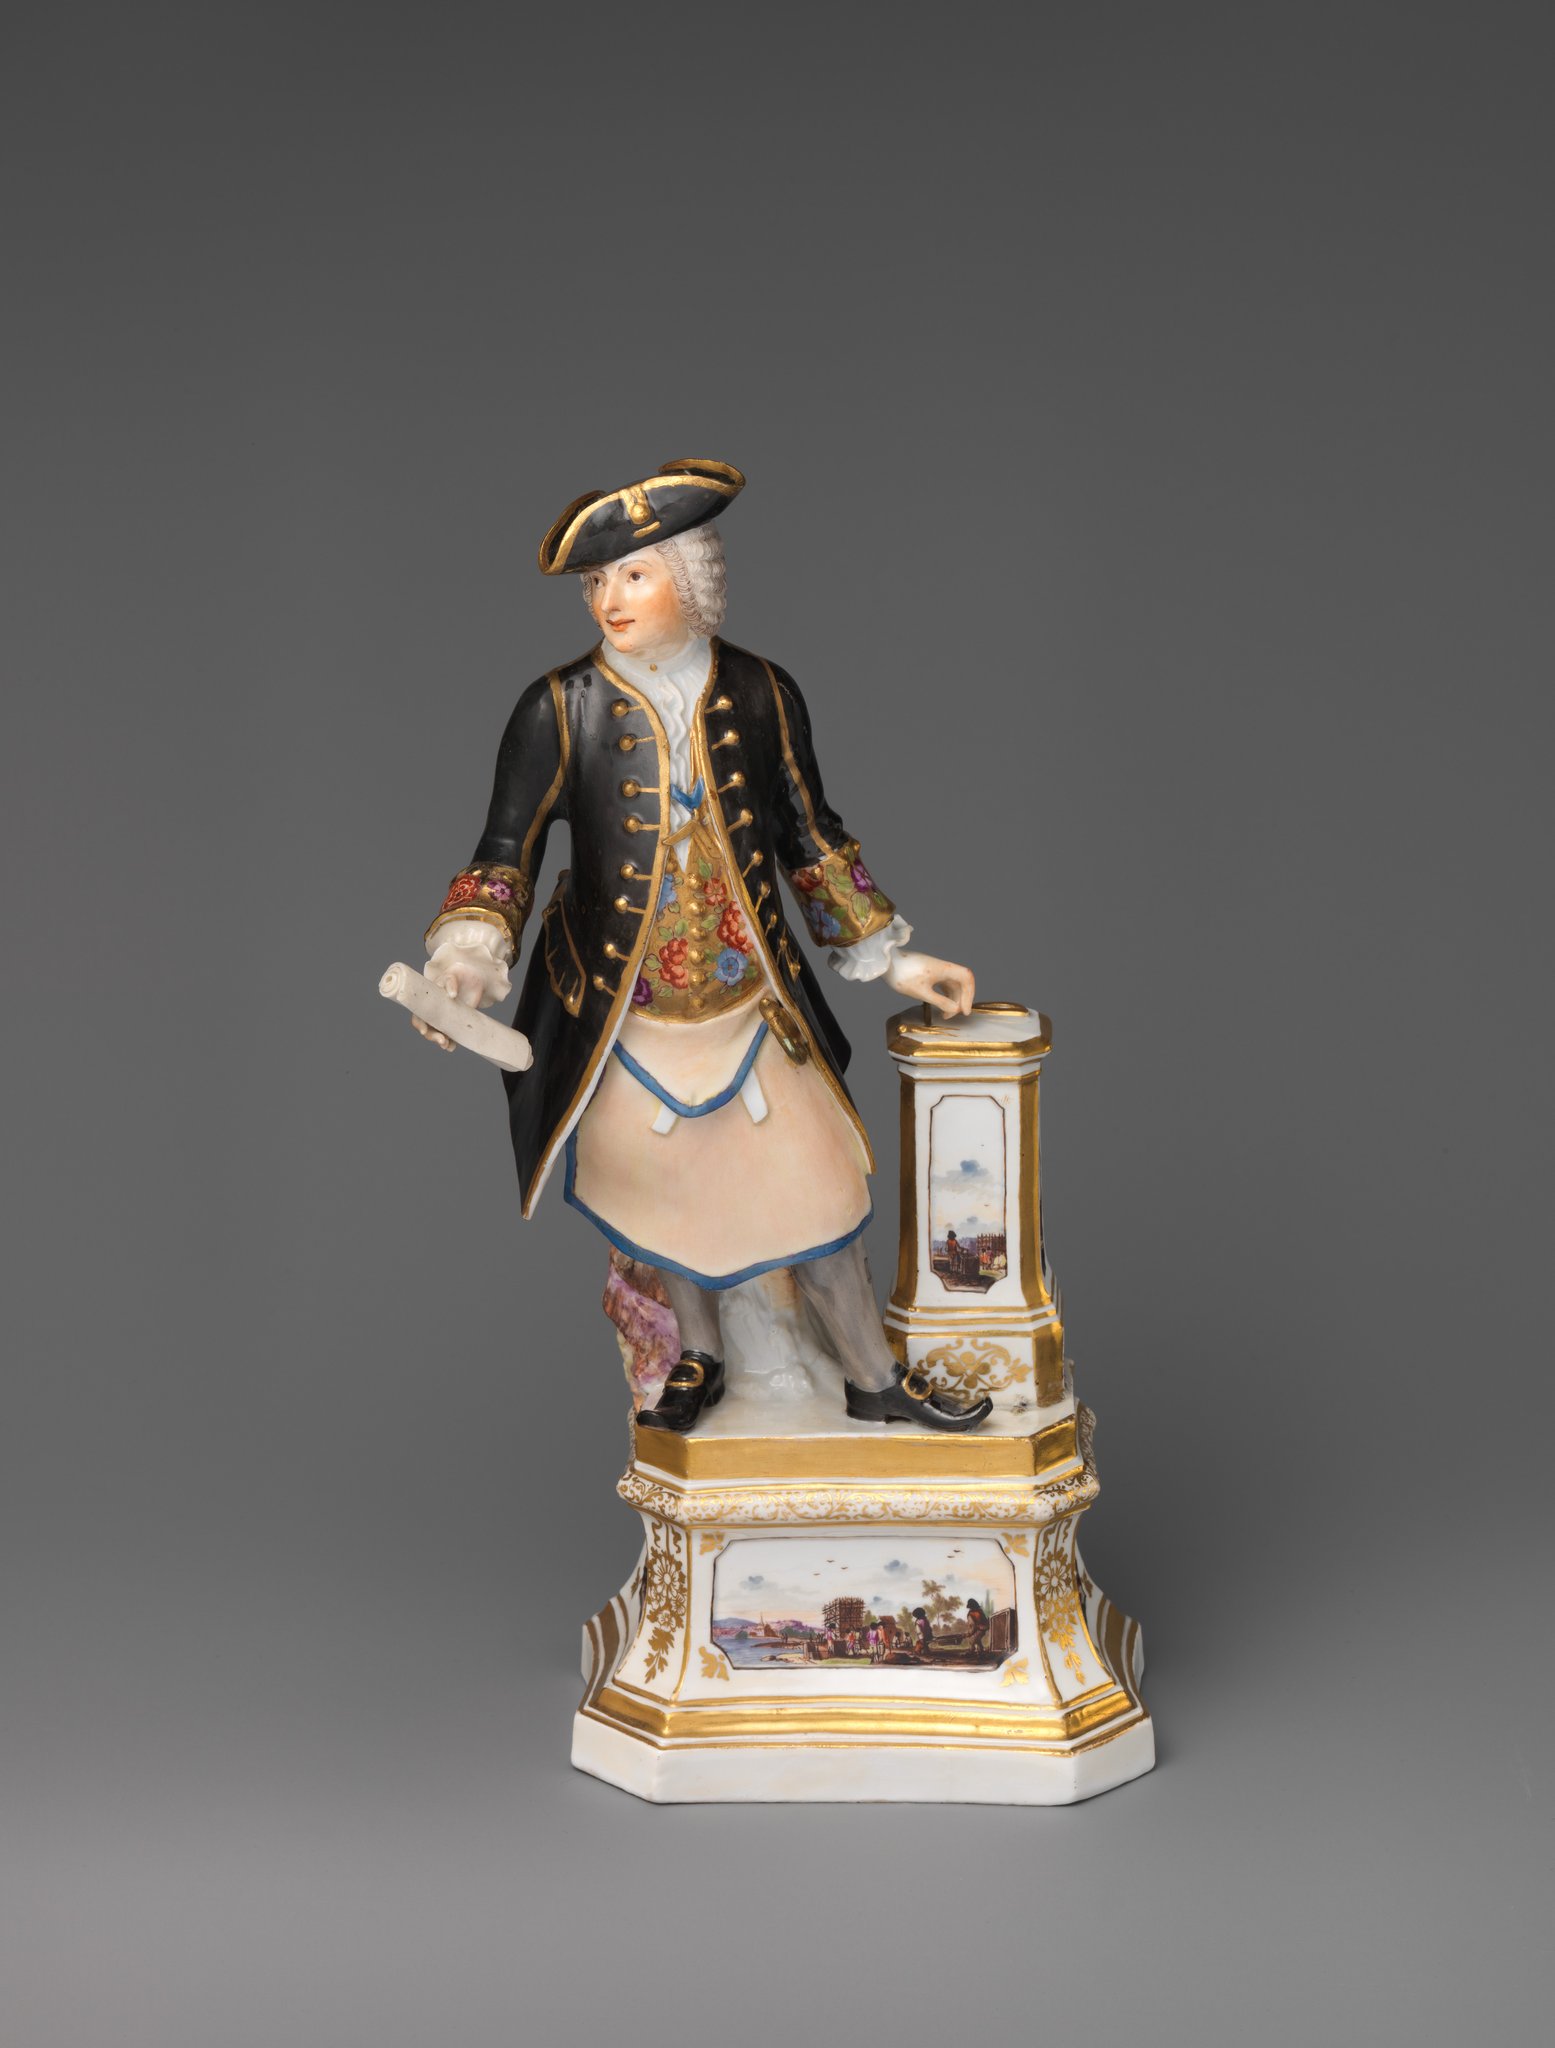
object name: figure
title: Freemason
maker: meissen manufactory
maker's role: manufactory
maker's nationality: german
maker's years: 1710-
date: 1744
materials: enamel, gold, hard paste porcelain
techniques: polychrome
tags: men